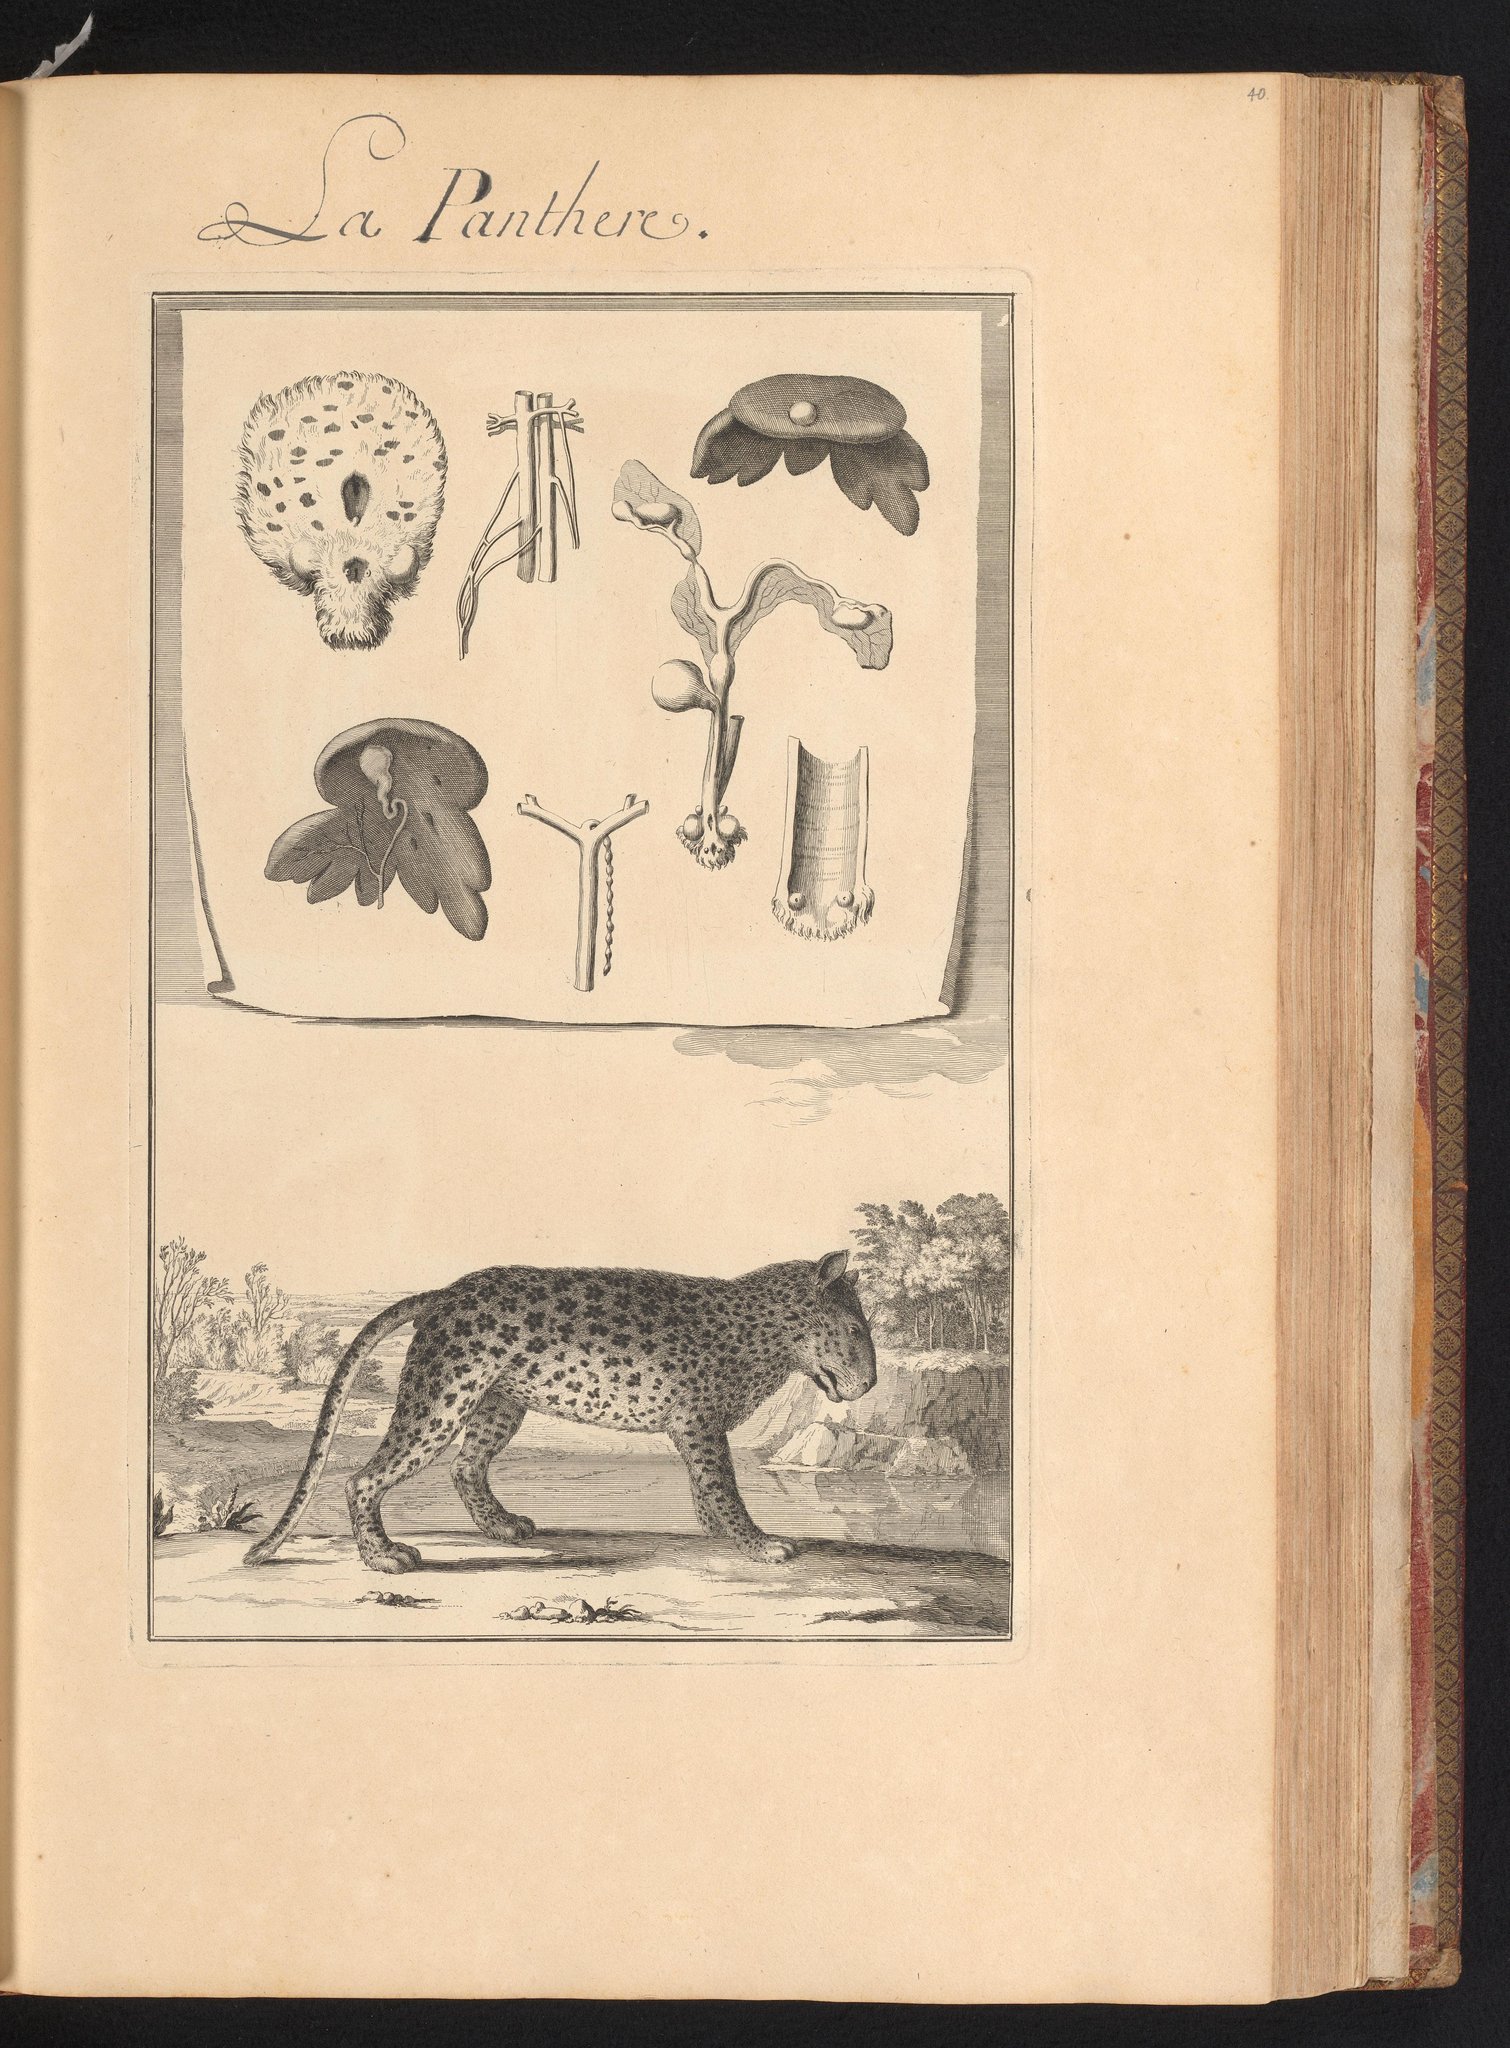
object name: album leaf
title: Panter of luipaard (panthera pardus) in een landschap met bovenaan op een blad de organen en botten van het dier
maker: sébastien leclerc (i)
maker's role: print maker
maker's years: 1637-1714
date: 1646-1714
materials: ink, paper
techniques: engraving, etching, pen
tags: beasts of prey, predatory animals: leopard, dissection, beasts of prey, predatory animals: panther, animals (+ anatomy of animals)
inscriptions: inscription: ‘La Panthere.’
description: Prent bedoeld voor een editie van Claude Perraults 'Mémoires pour servir à l'histoire naturelle des animaux'.